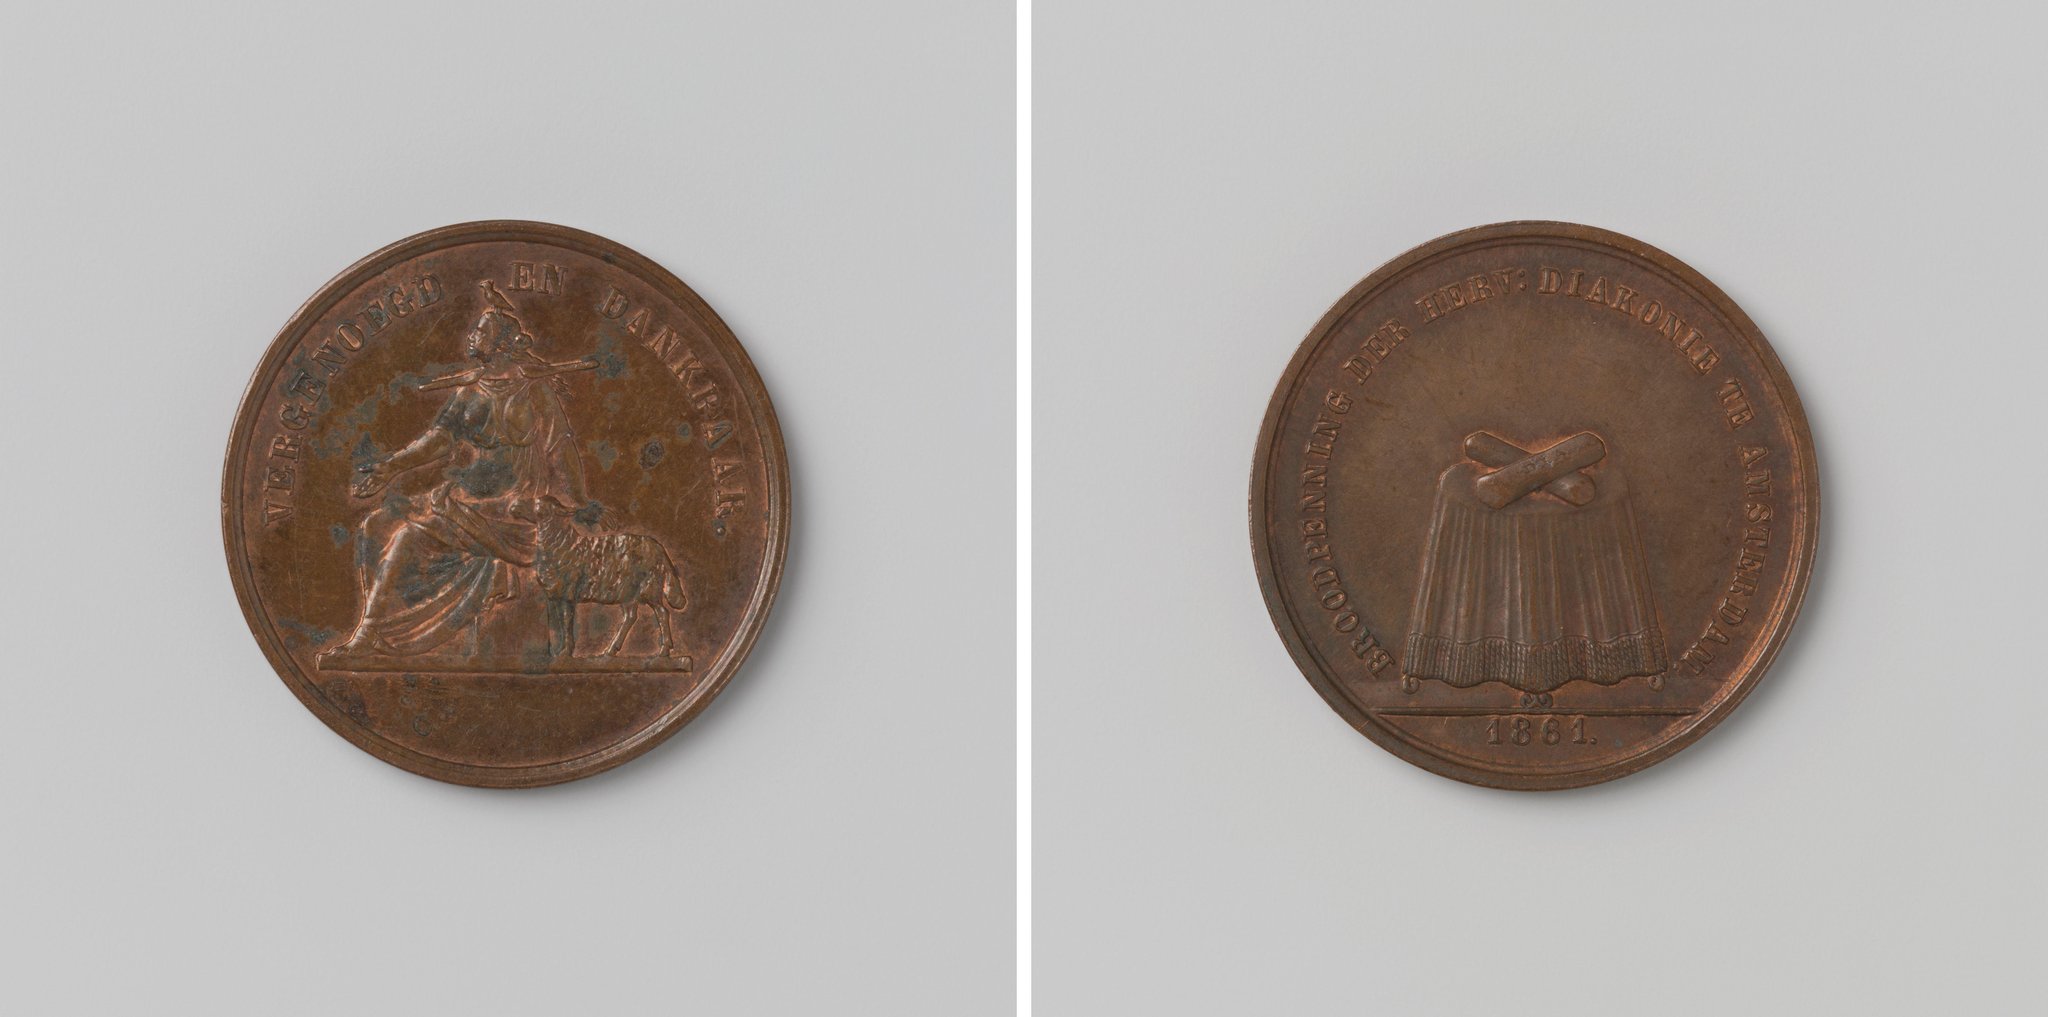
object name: broodpenning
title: Hervormde Diakonie te Amsterdam, armenpenning die behoeftige kerklidmaten bij uitdeling recht gaf op brood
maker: david van der kellen (1804-1879)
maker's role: die cutter, draughtsman, print maker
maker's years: 1804-1879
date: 1861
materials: copper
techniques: striking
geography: amsterdam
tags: amsterdam